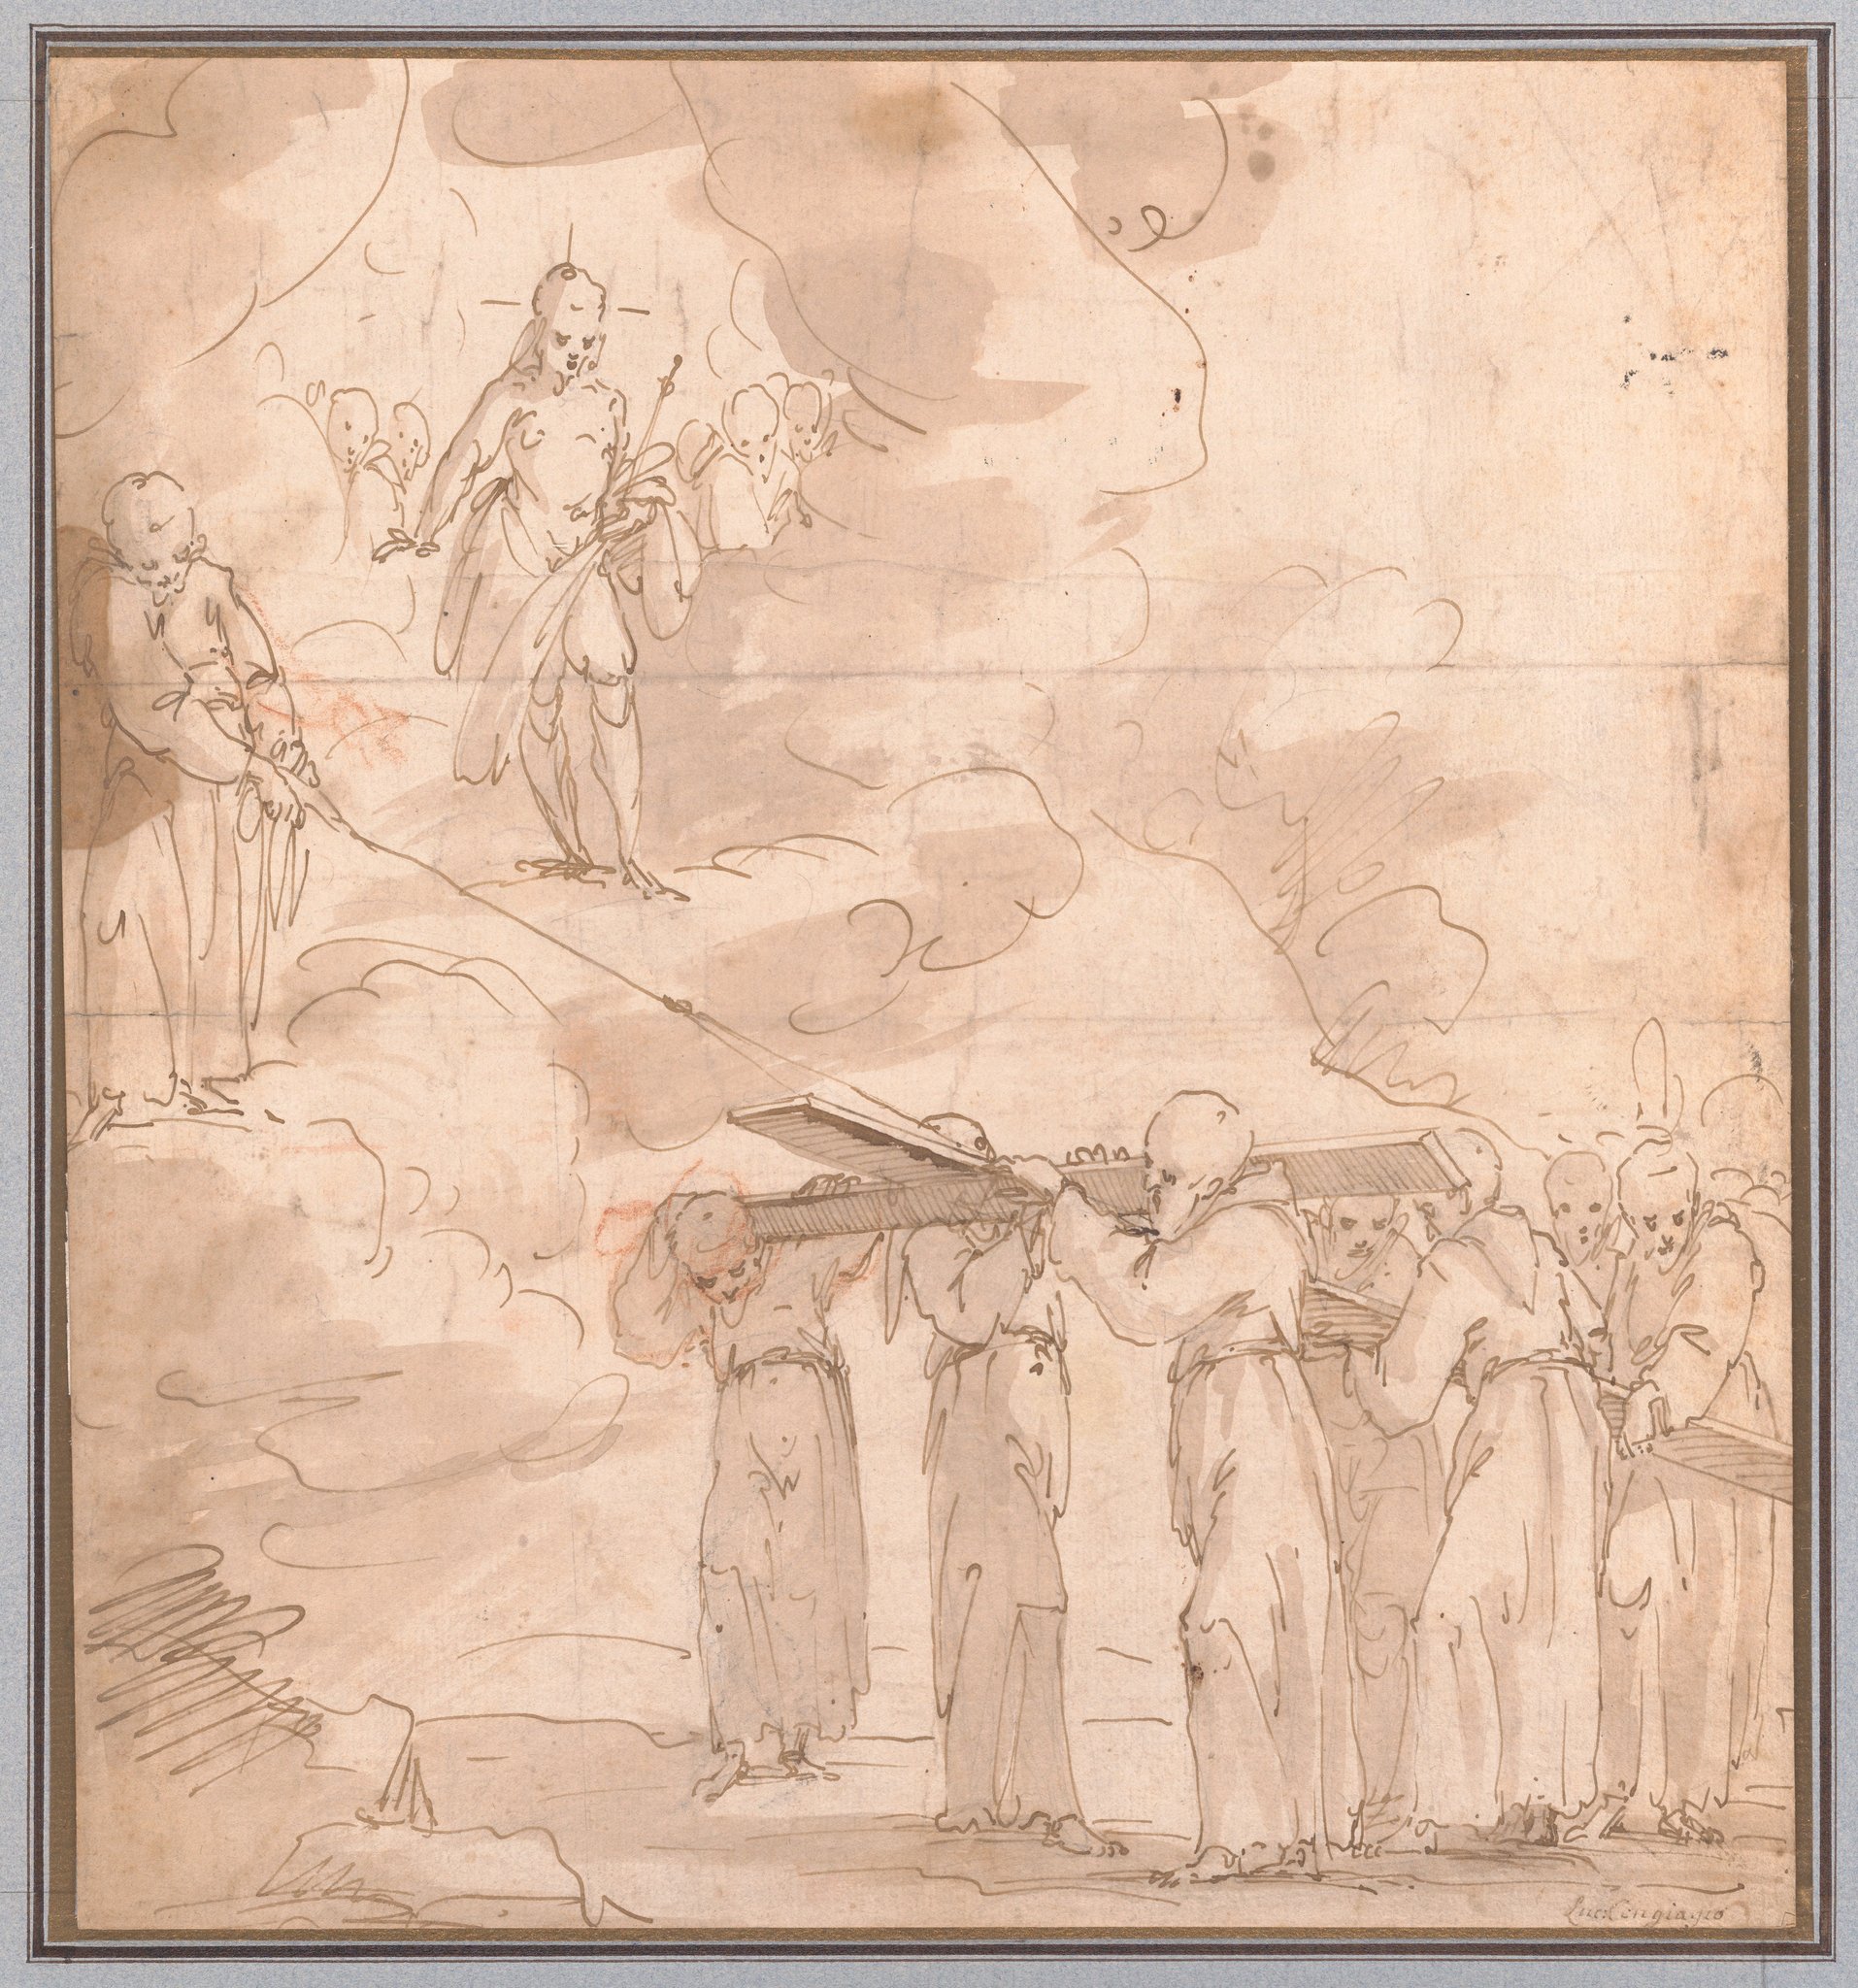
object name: drawing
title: Members of a Monastic Order Carrying the Cross for Christ to Heaven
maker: giovanni andrea de ferrari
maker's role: artist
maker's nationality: italian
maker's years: 1598-1669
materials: chalk, ink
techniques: pen, wash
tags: christ,cross